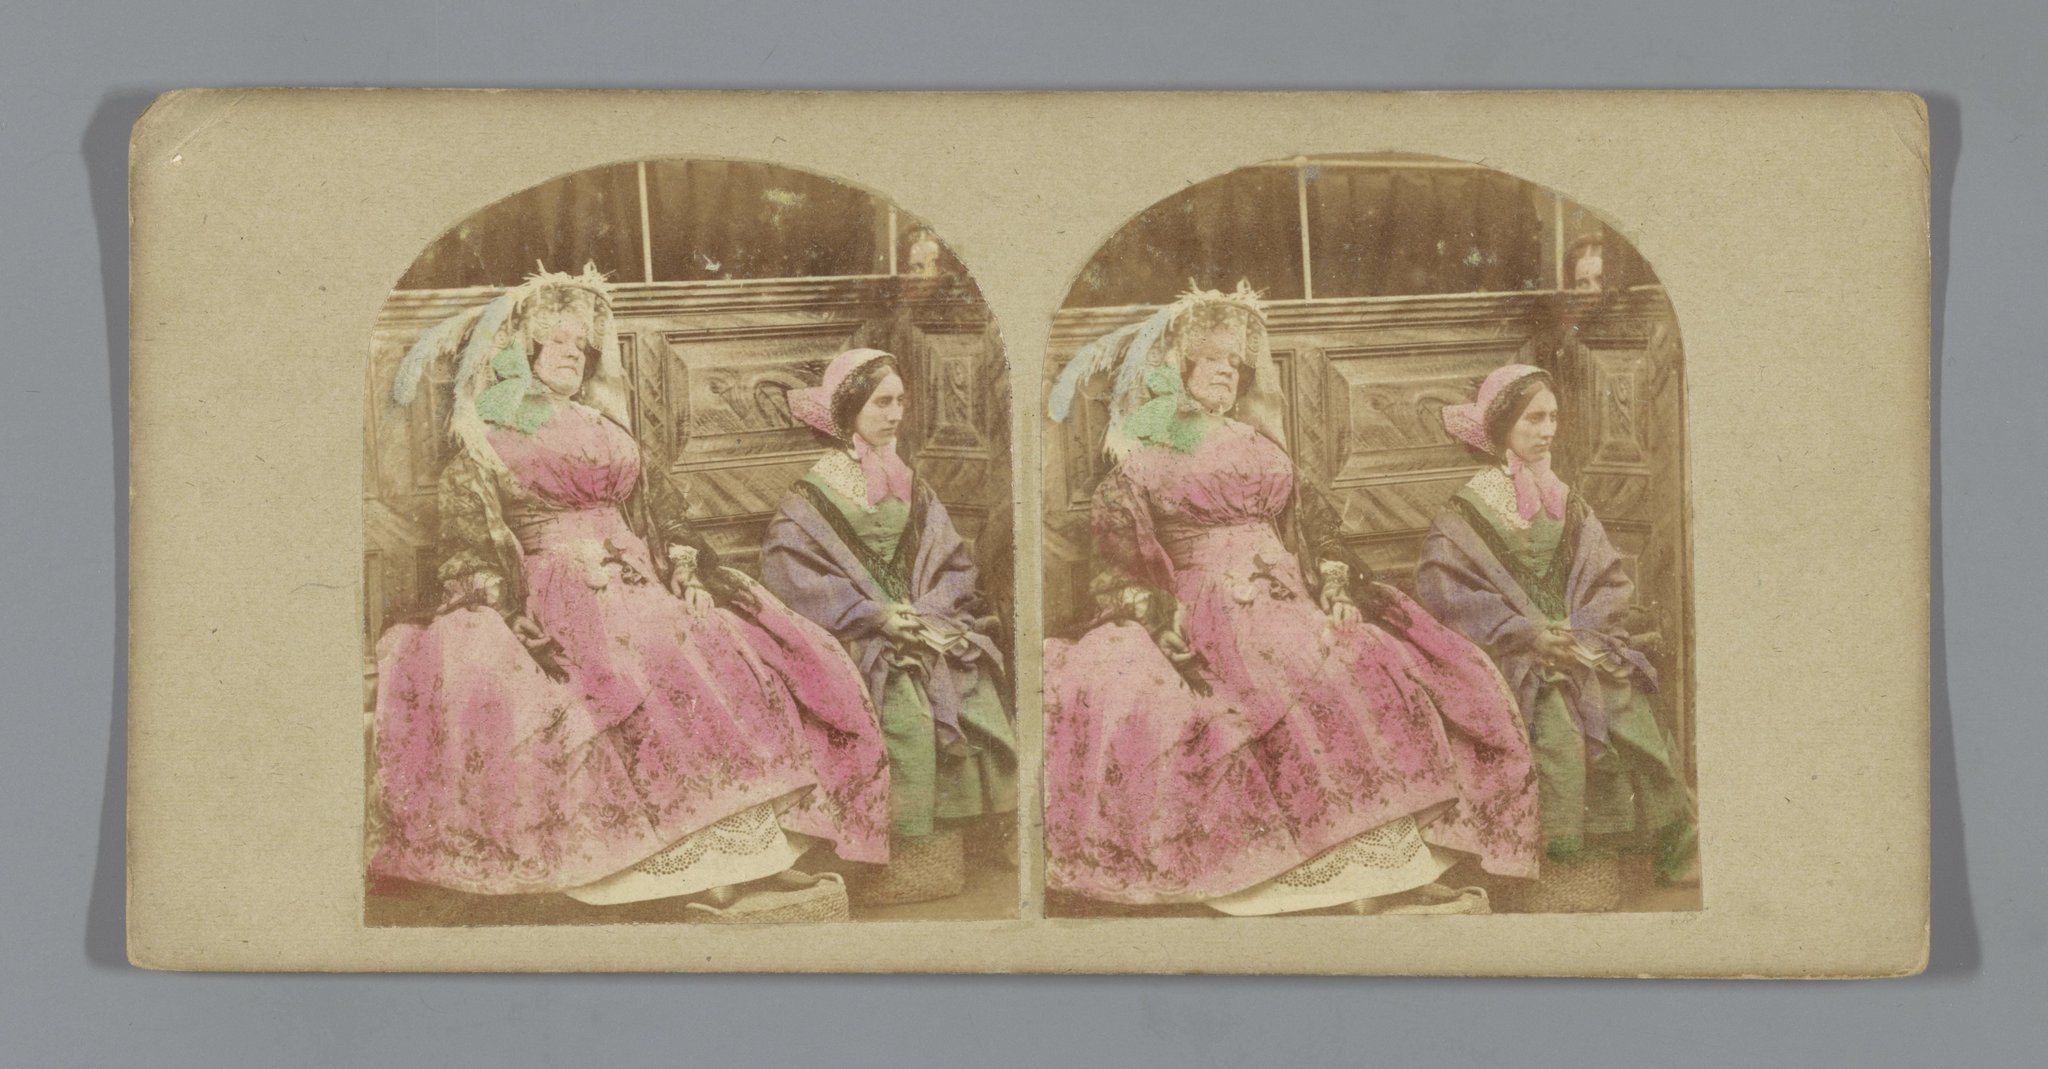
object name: stereograph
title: Twee vrouwen worden begluurd door een derde vrouw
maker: Anonymous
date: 1852-1863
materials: cardboard, paper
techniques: albumen print, hand coloring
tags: sleeping; unconsciousness